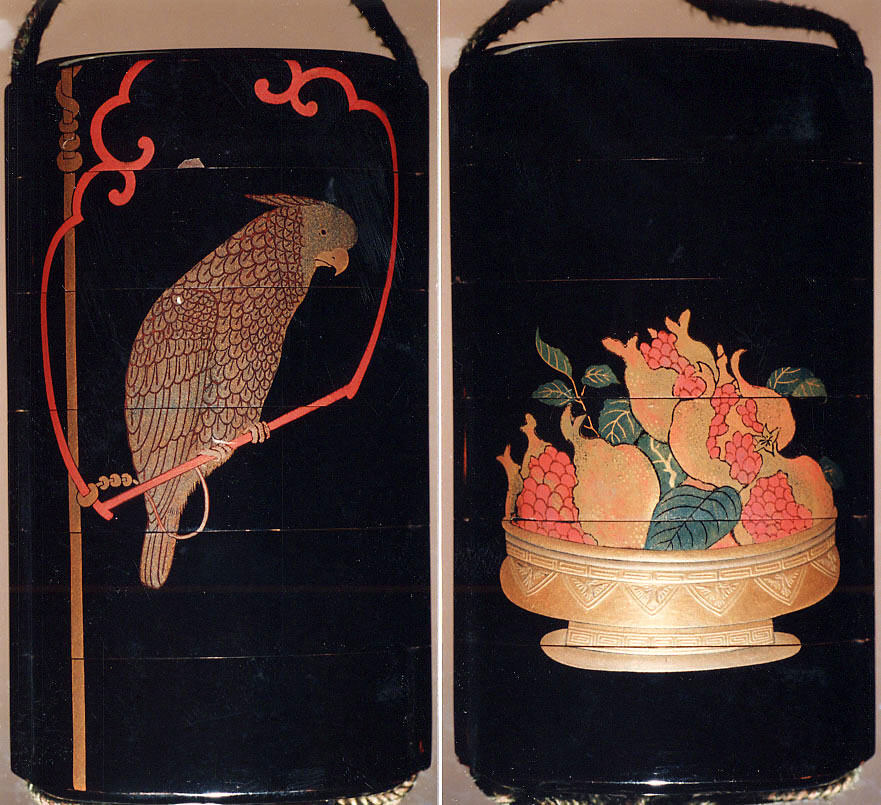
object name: inrō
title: Case (Inrō) with Design of Parrot on Swing (obverse) Basket of Pomegranates (reverse)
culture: japanese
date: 1701-1900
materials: gold, lacquer, silver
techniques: fundame, roiro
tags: fruit,parrots